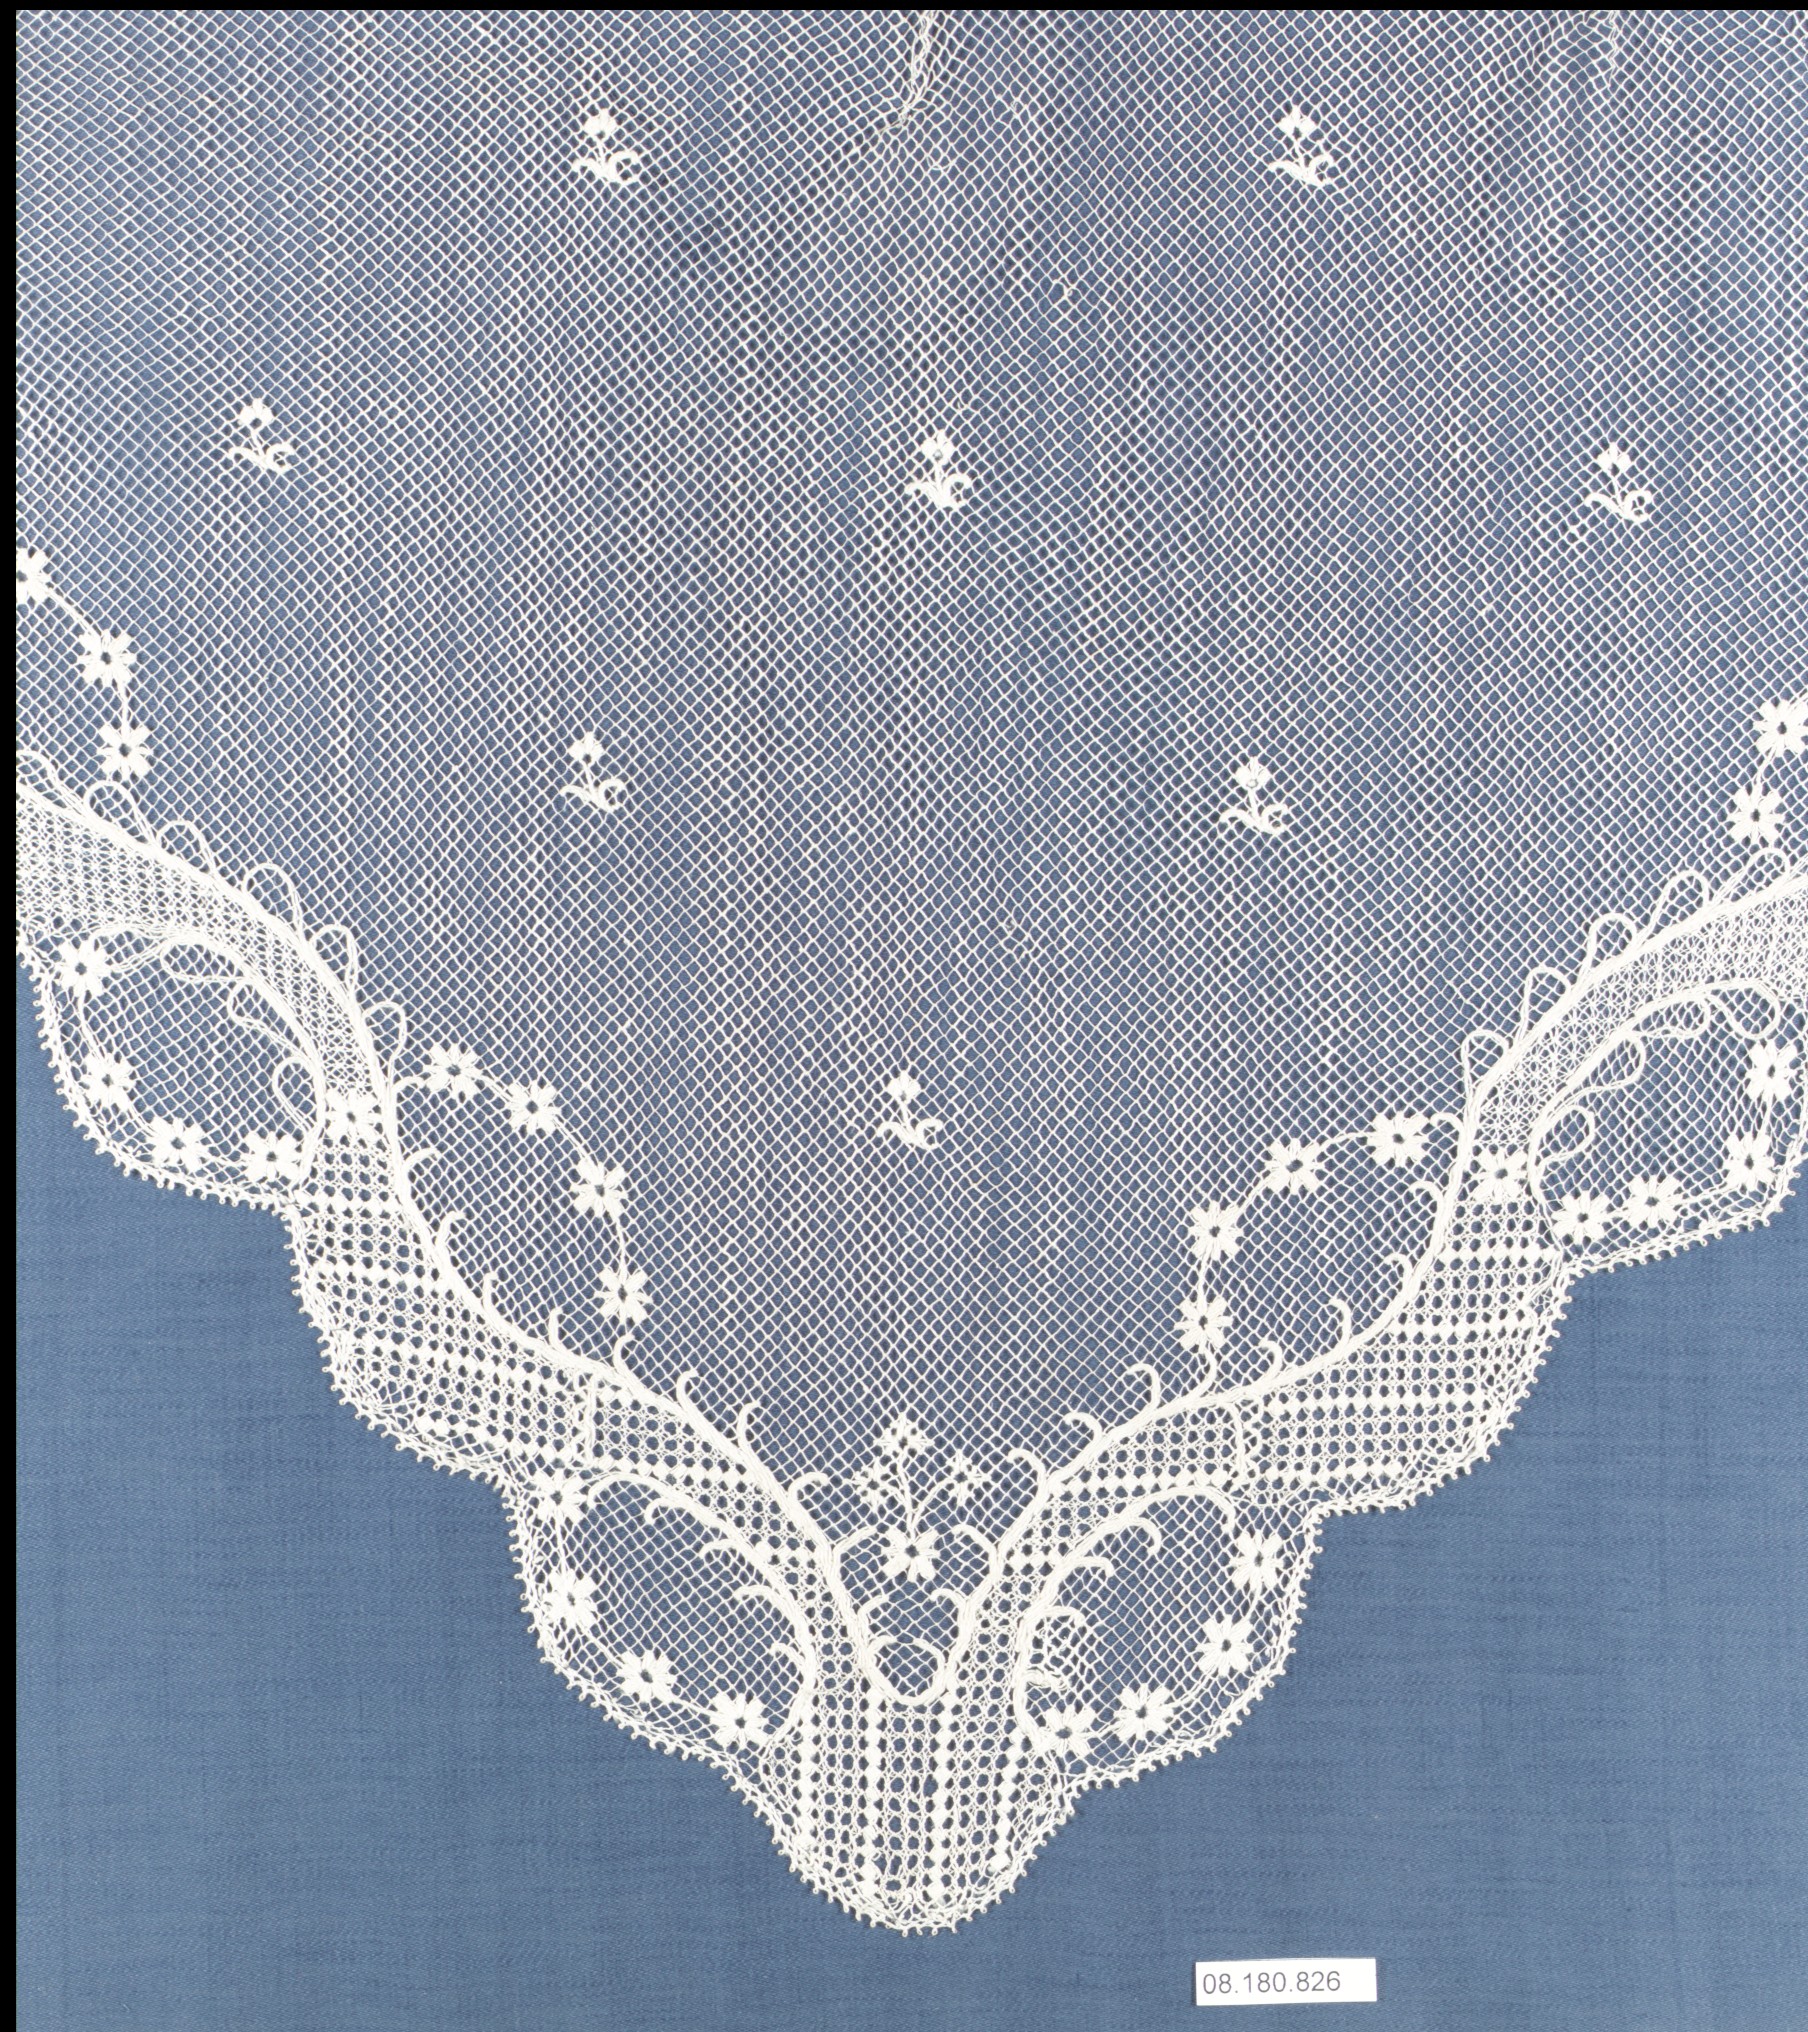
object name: fichu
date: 1801-1900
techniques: embroidery